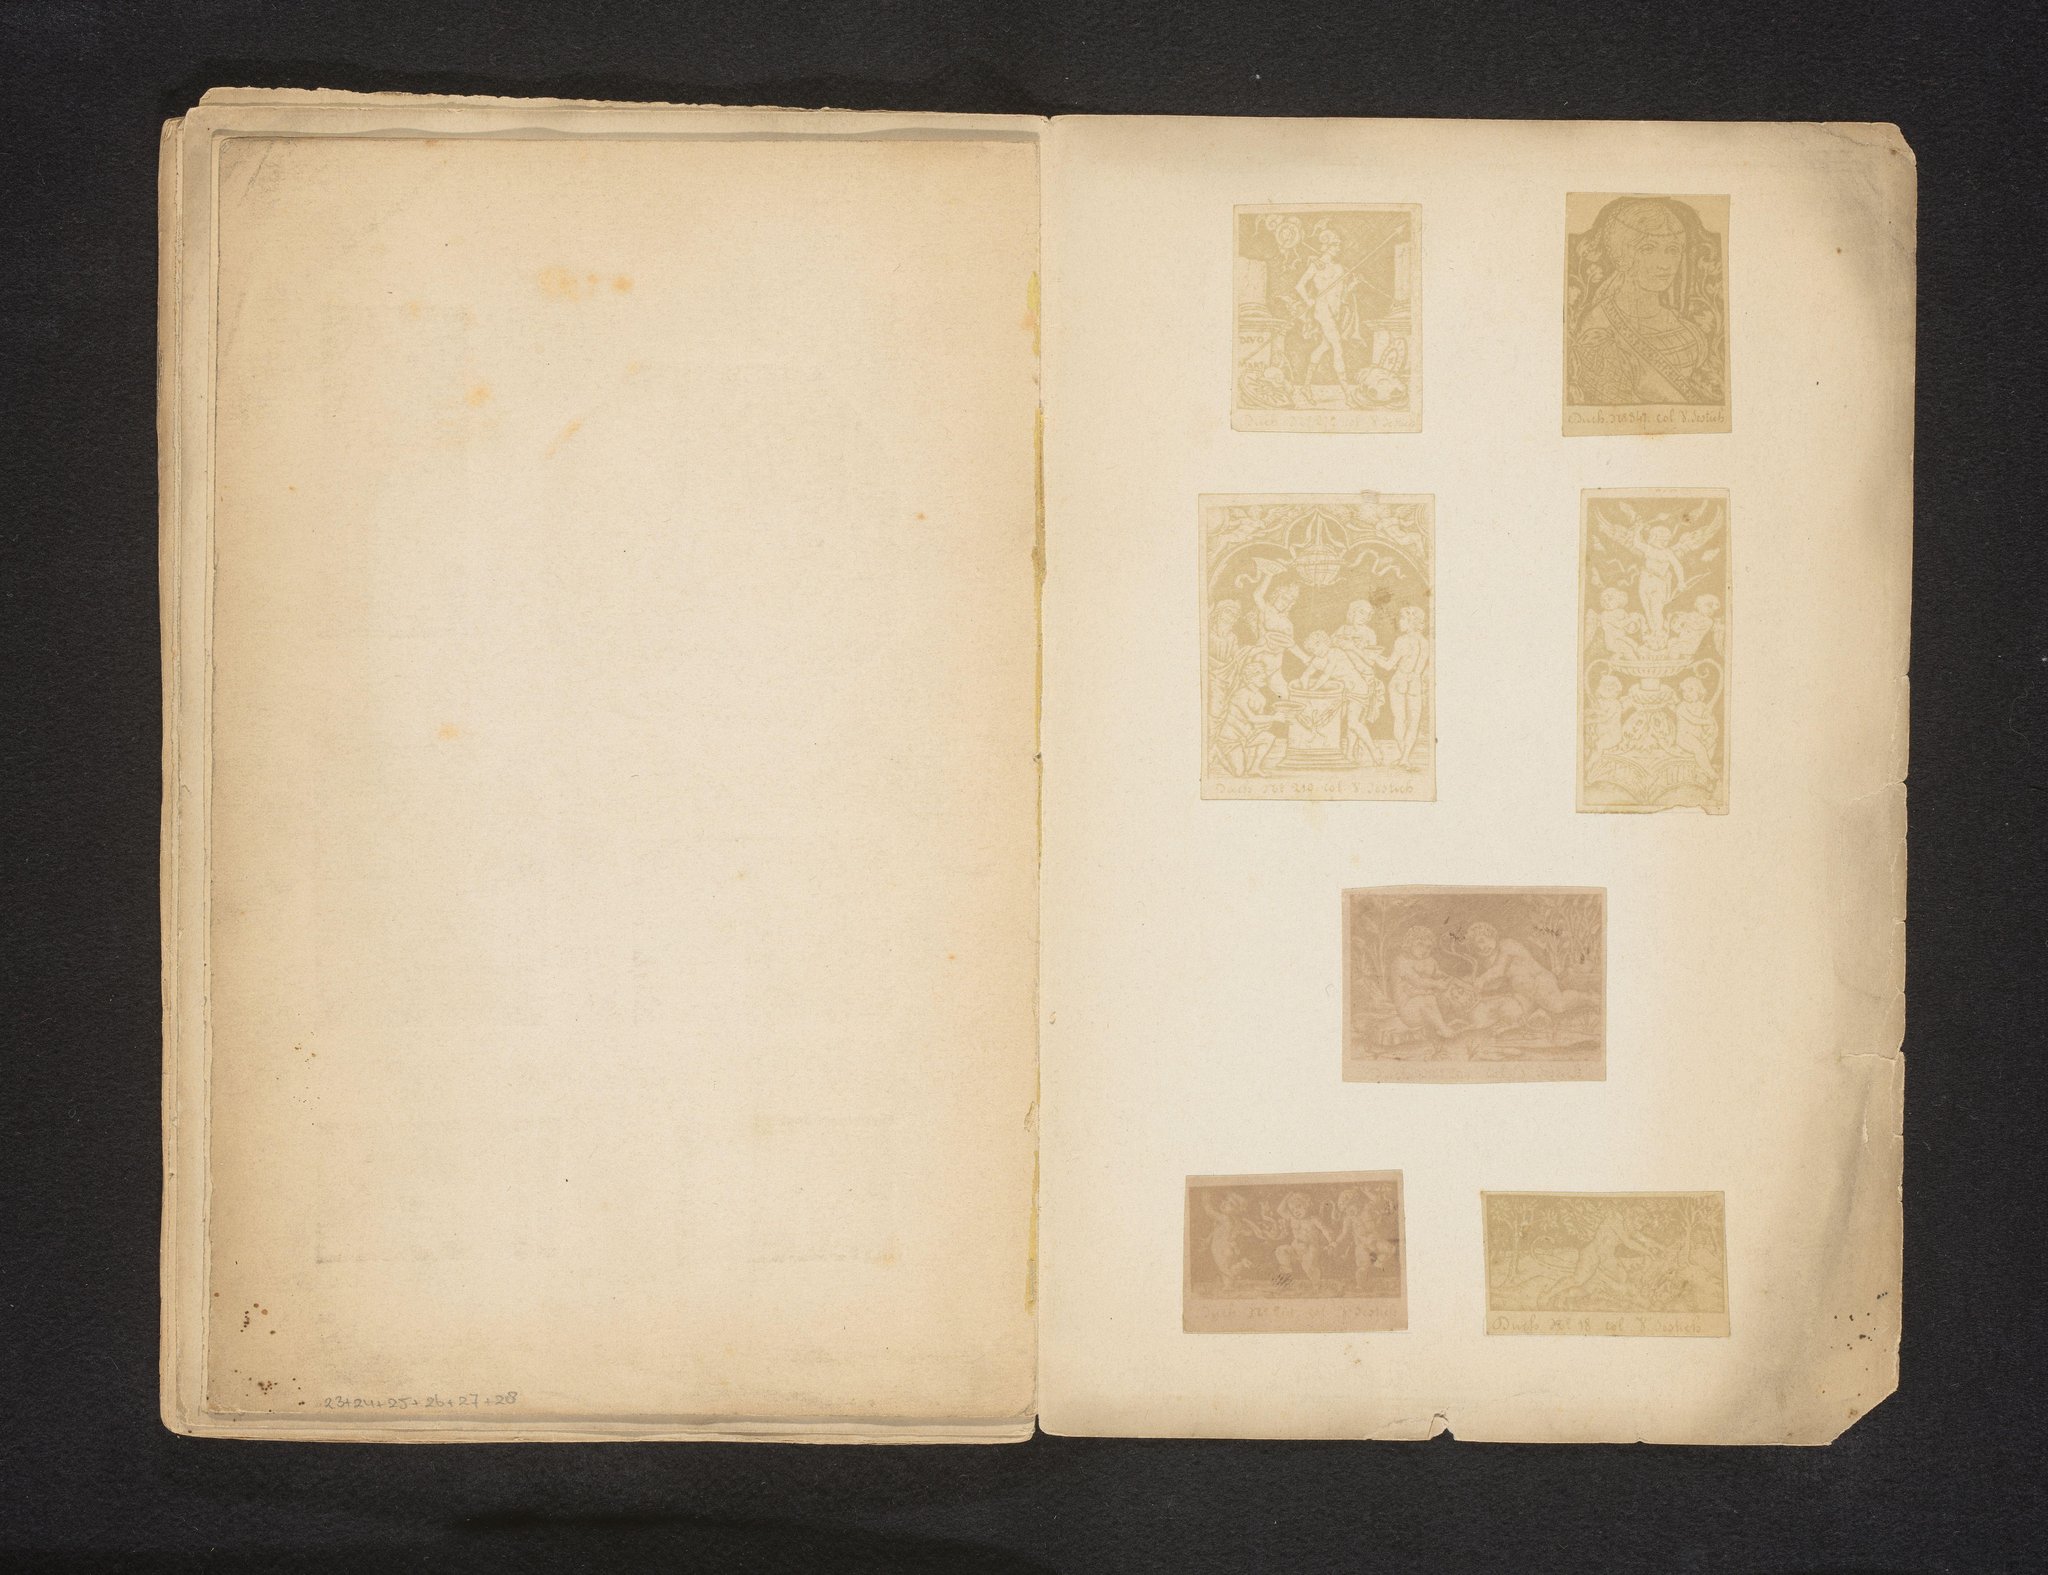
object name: reproduction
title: Fotoreproductie van een prent van twee kinderen die met een hond spelen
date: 1852-1857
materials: photographic support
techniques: salted paper print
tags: child, dog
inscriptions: inscription: ‘Duch. [No 294.] Col. V. Sestich’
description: Foto op blad met zeven foto's op negende ongenummerde pagina na pagina 60.